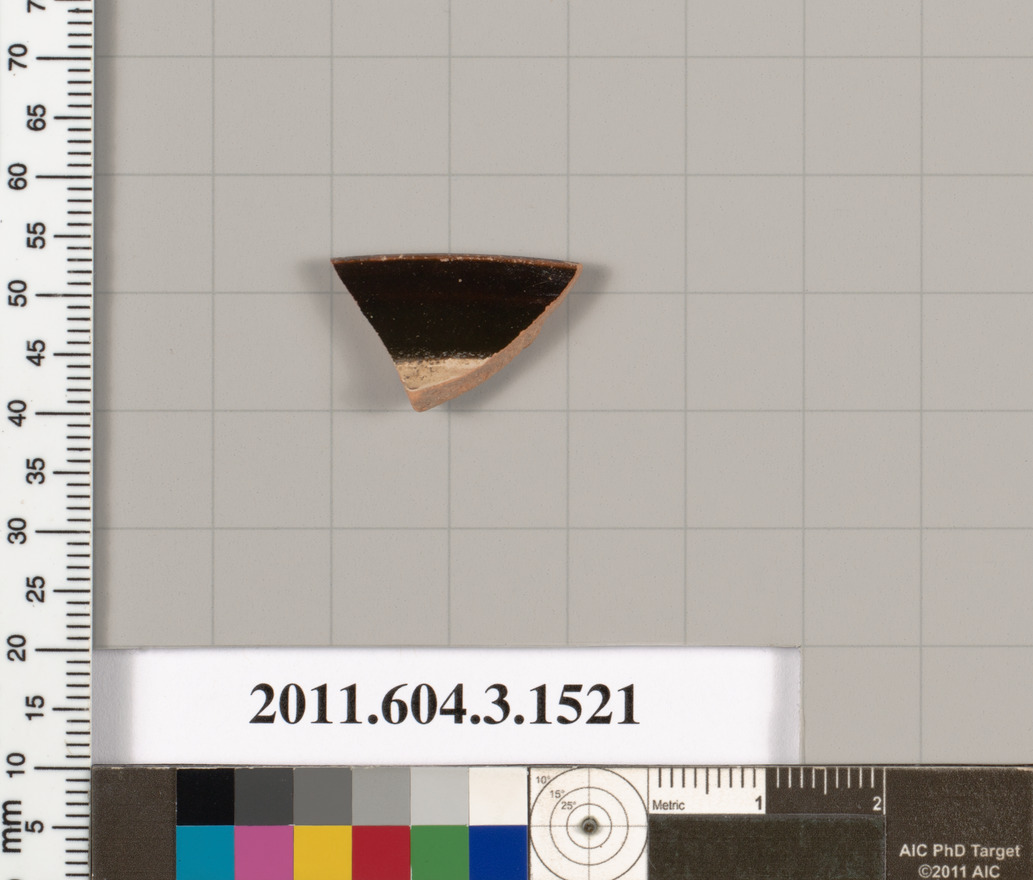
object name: mastoid fragment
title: Terracotta fragment of a mastoid (drinking cup with narrow base)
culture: greek, attic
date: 500-468 BCE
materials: terracotta